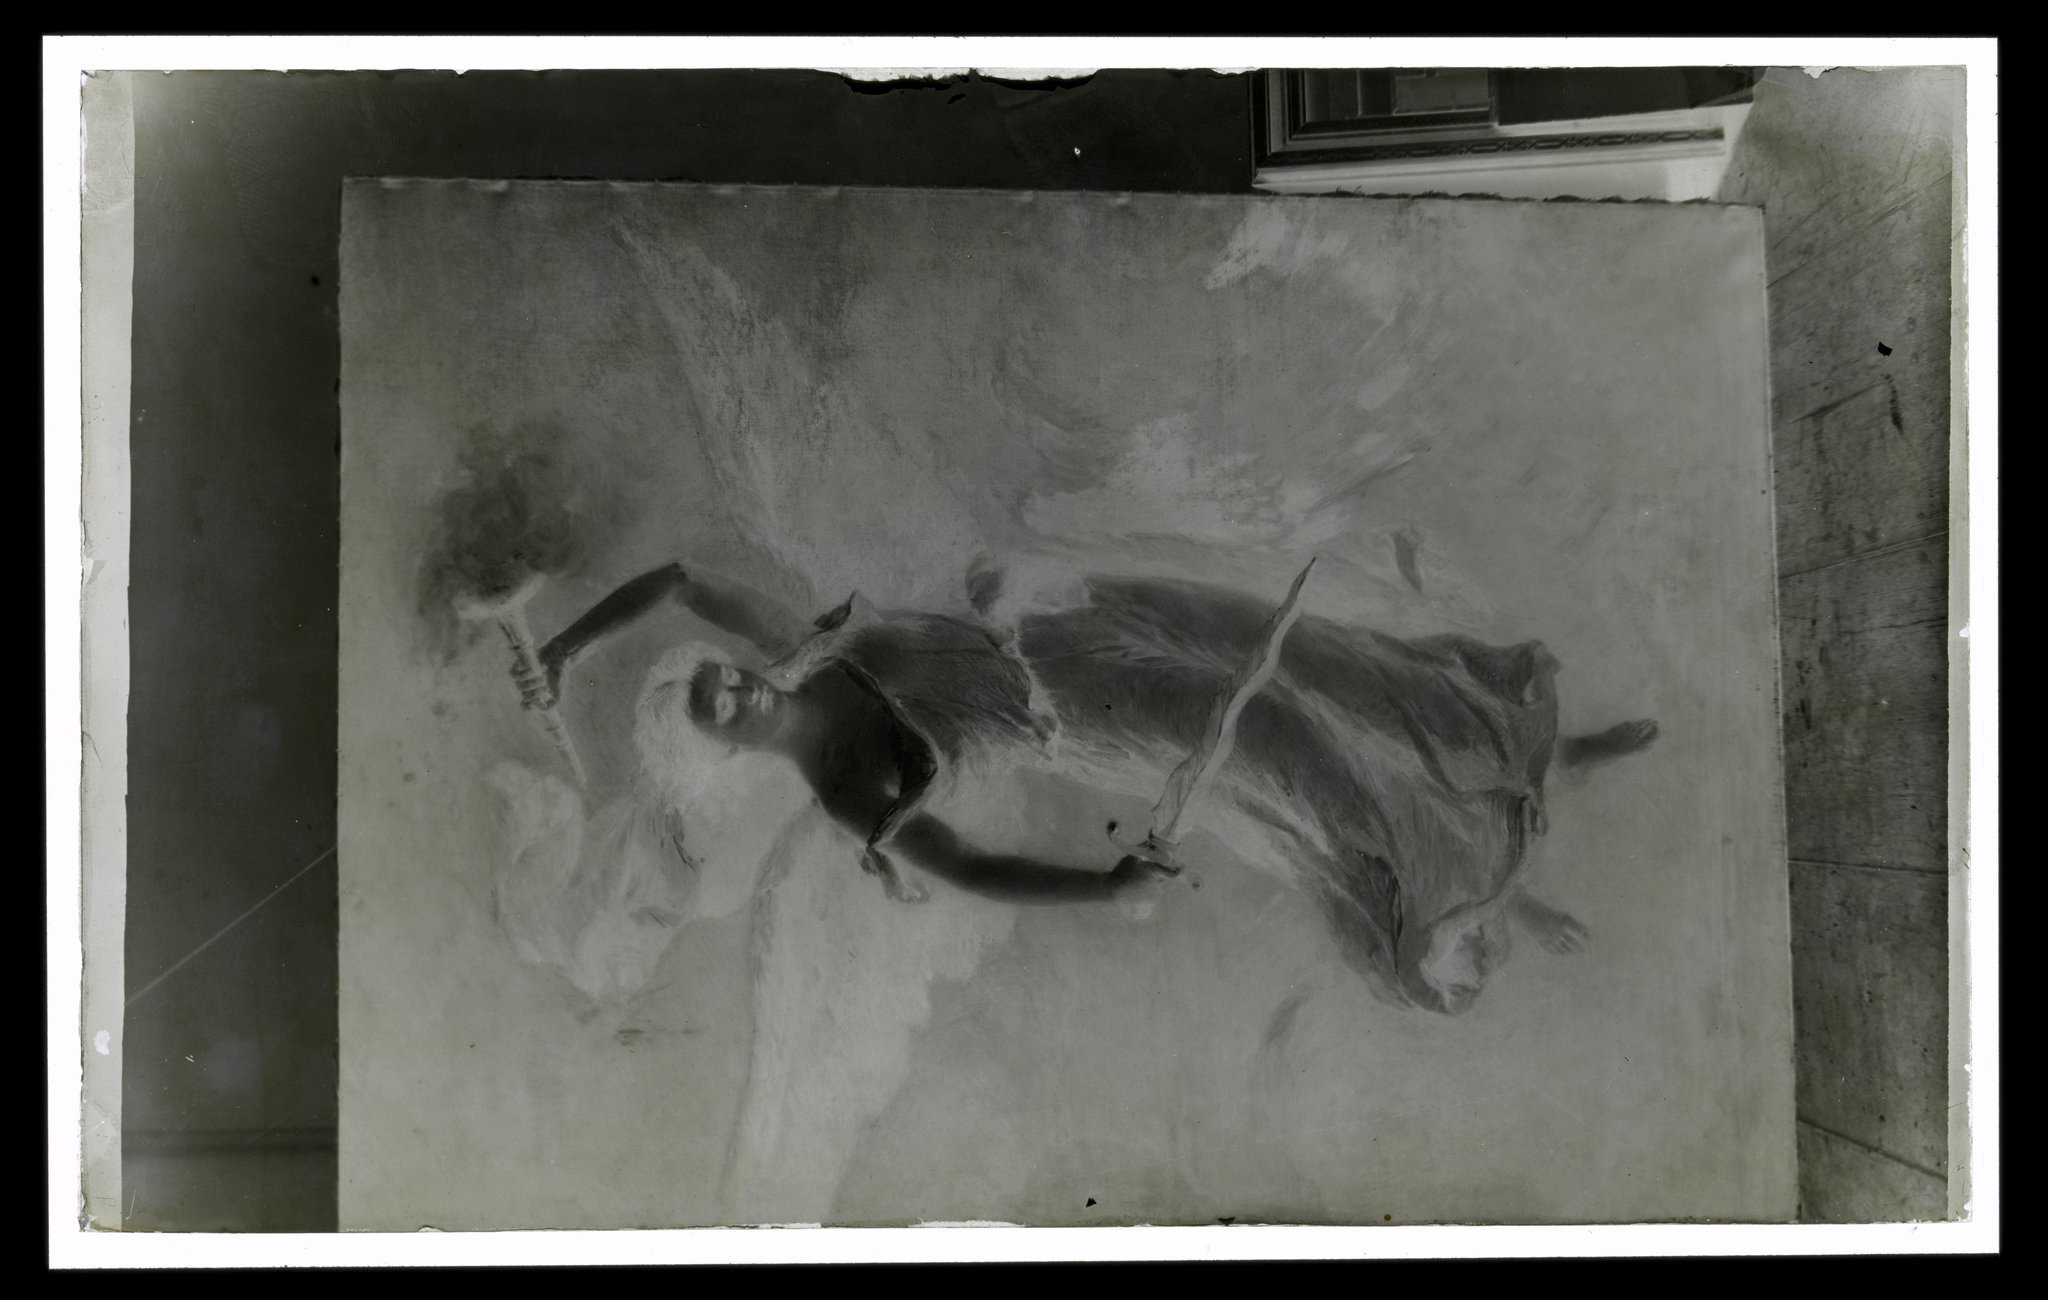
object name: reproduction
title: Fotoreproductie van een schilderij van een engel met brandende fakkel en zwaard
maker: laurens lodewijk kleijn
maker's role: draughtsman, painter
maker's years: 1826-1909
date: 1865-1900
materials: glass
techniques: collodion process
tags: angels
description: Onderdeel van een groep glasnegatieven uit de nalatenschap van de schilder Laurens Lodewijk Kleijn, met stillevens, portretten, zelfportretten en kunstreproducties.